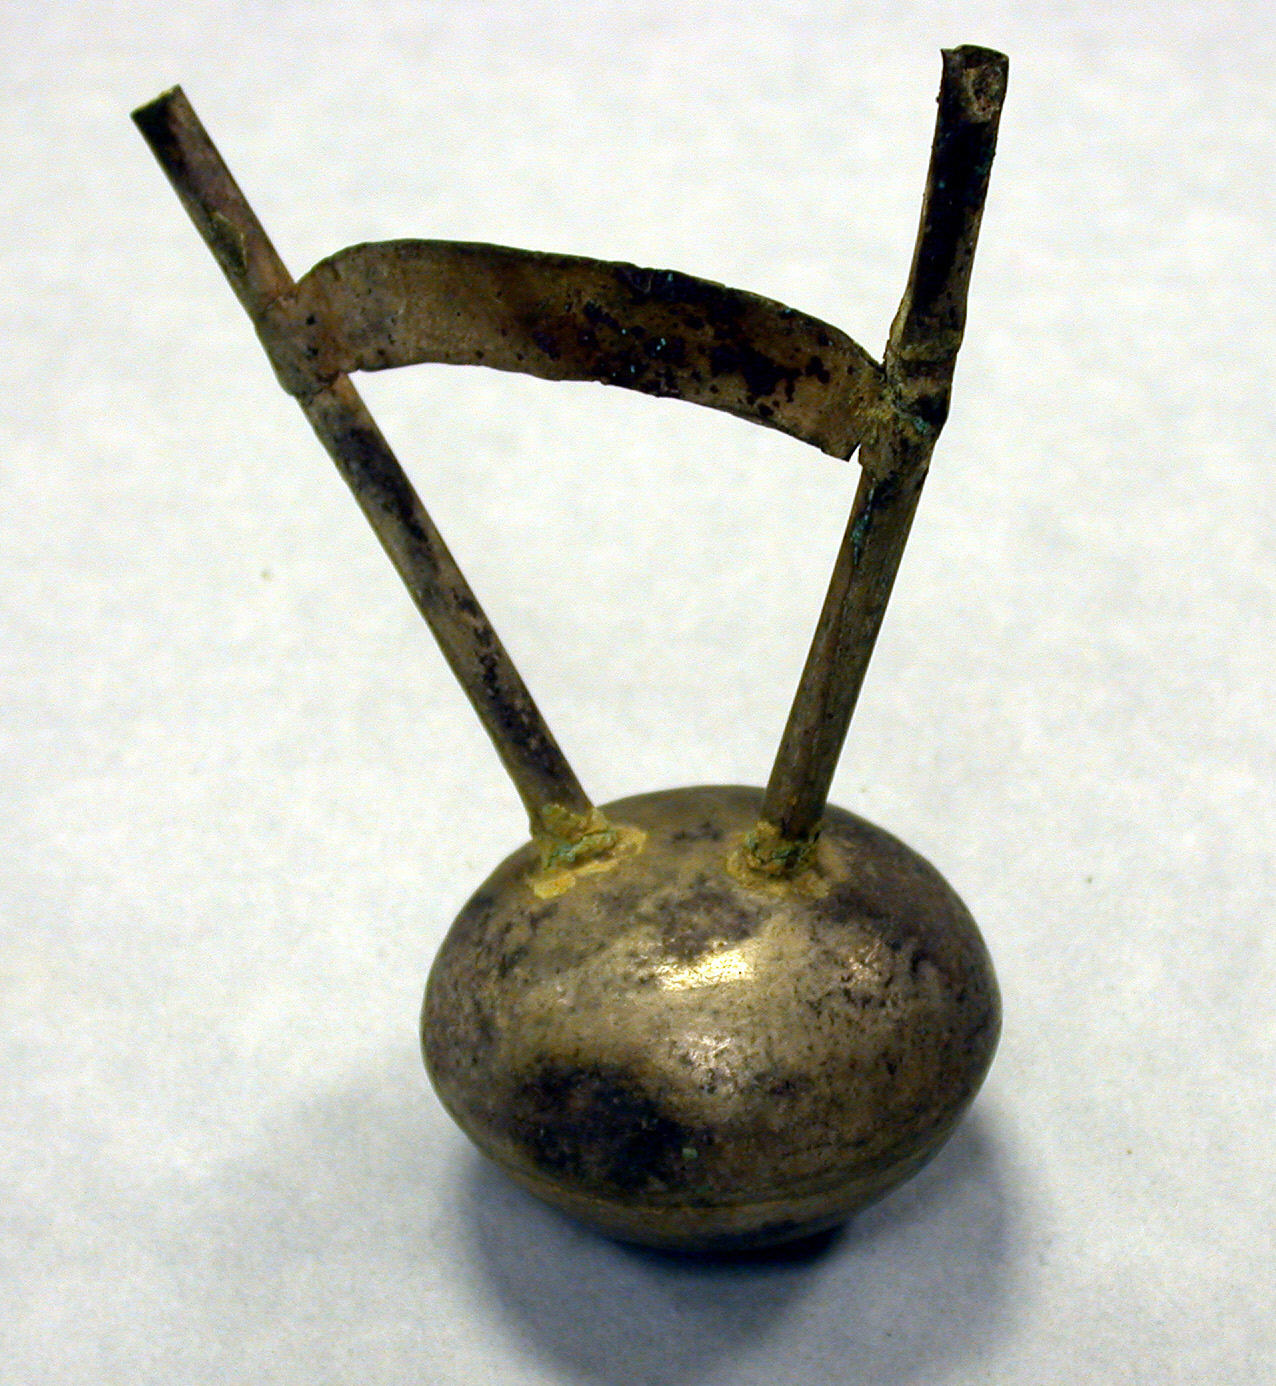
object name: bottle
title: Miniature Bottle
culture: chancay or chimú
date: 1001-1500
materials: gilt, silver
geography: peru